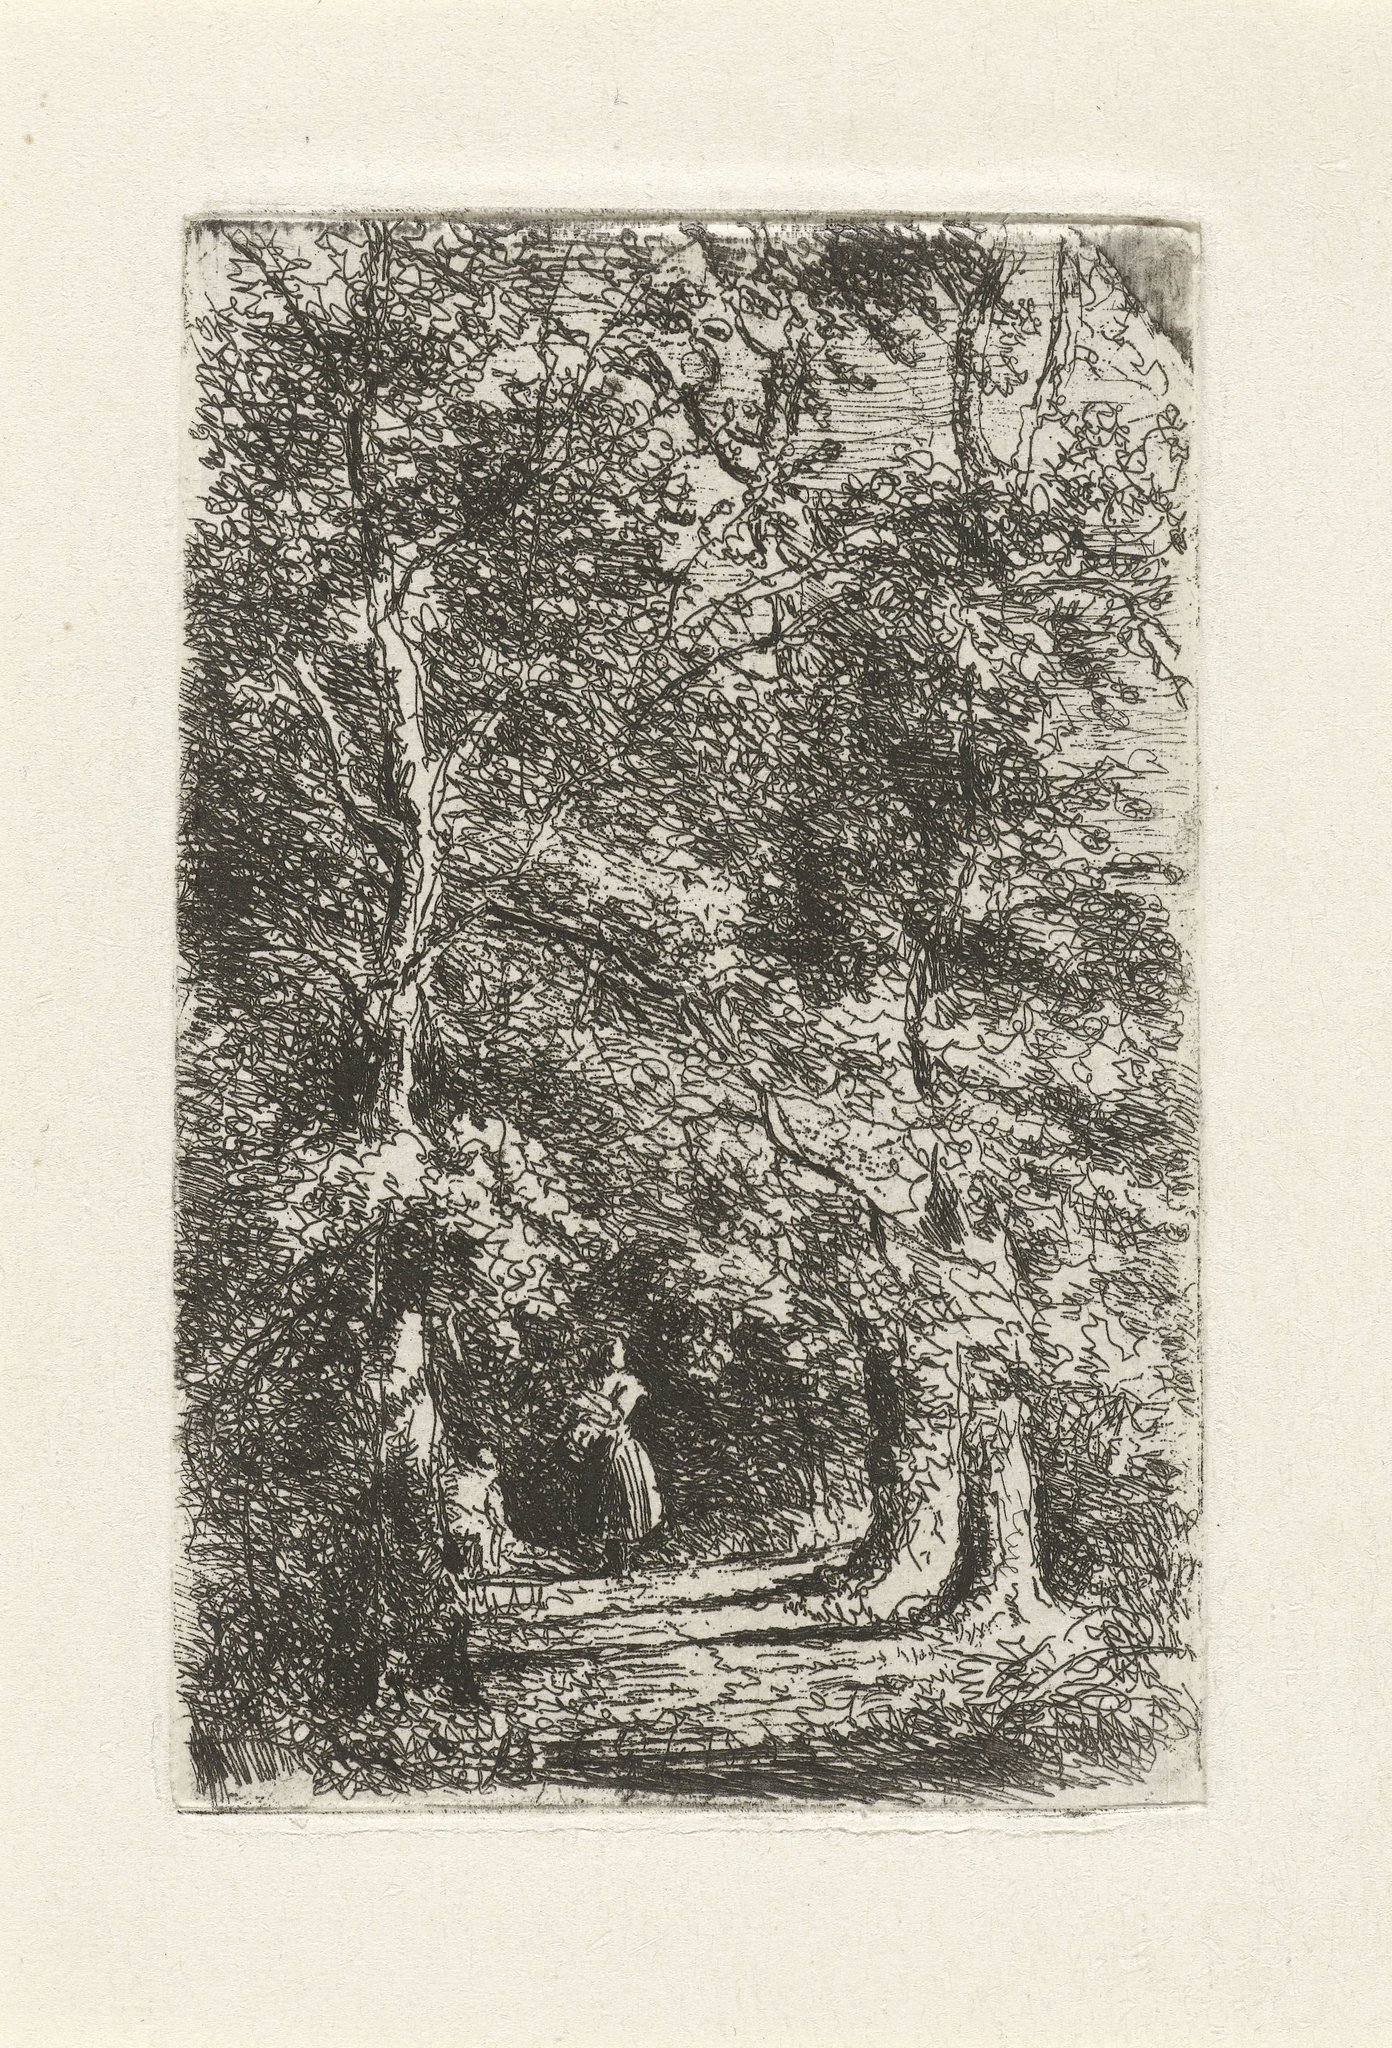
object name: print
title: Vrouw op bospad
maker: j. breuhaus de groot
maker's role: print maker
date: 1900-1999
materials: paper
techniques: etching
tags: forest path or lane